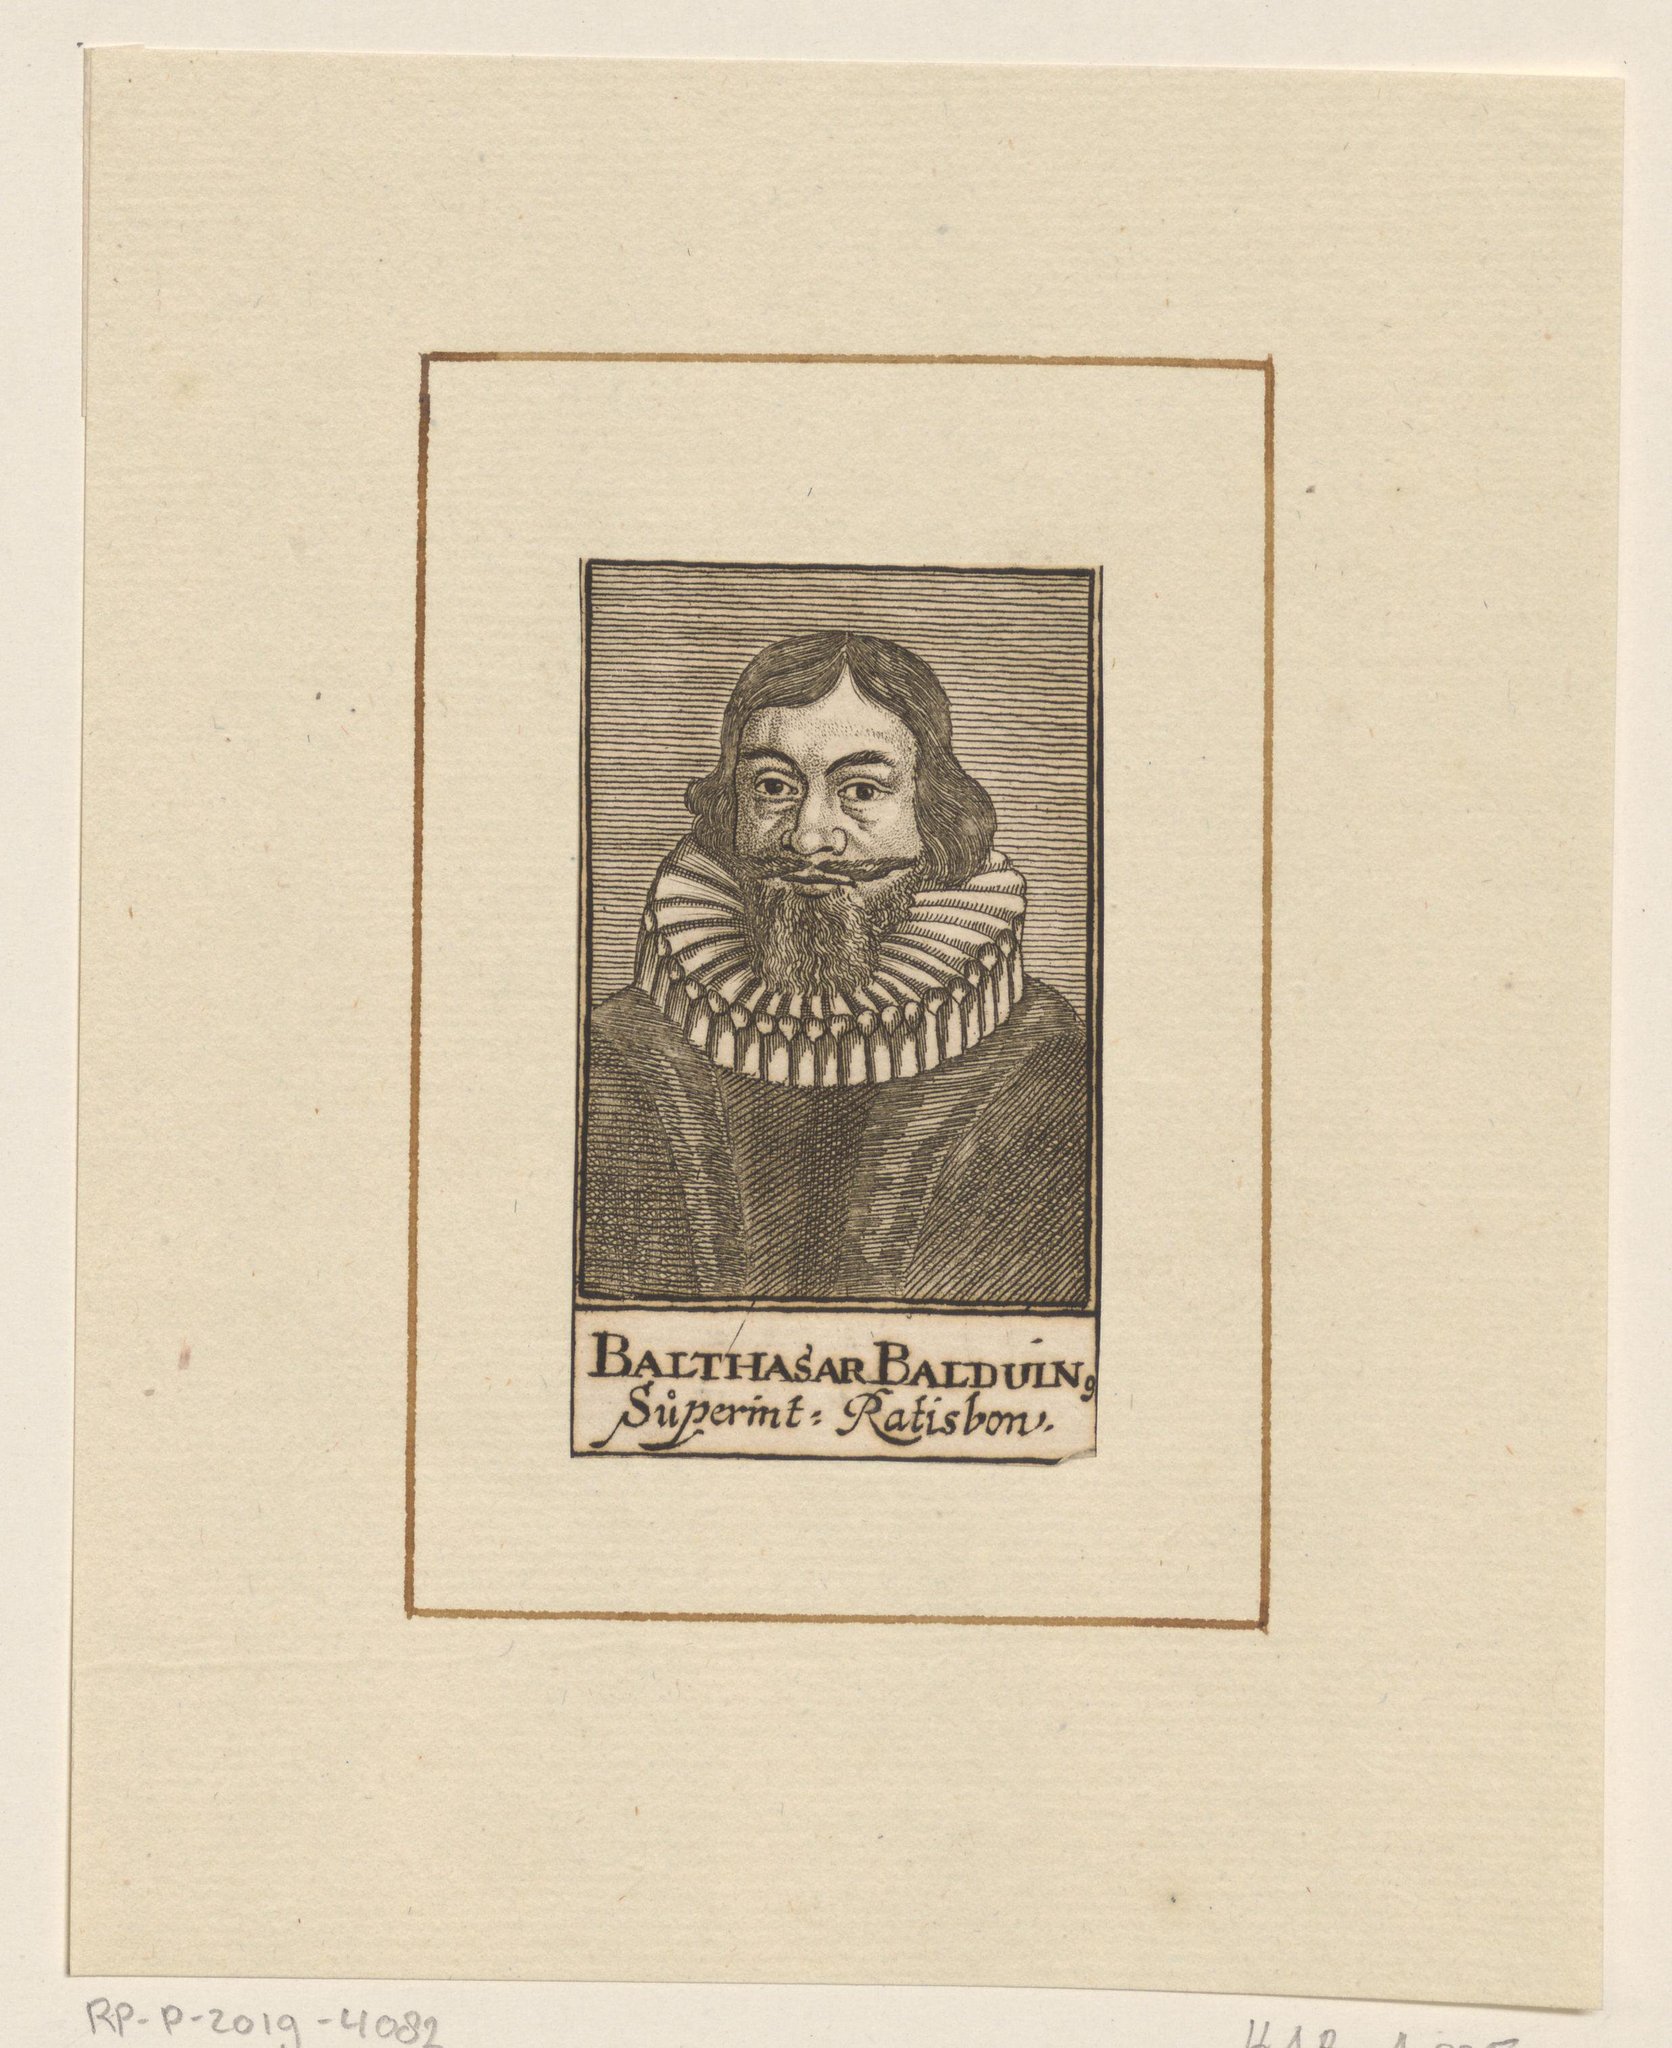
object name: print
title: Portret van Balthasar Balduin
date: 1688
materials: paper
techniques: engraving, etching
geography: nuremberg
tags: theologian, historical persons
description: Prent uit: Freher, Paul. Theatrum virorum eruditione clarorum. Neurenberg: Johann Hoffmann, 1688.